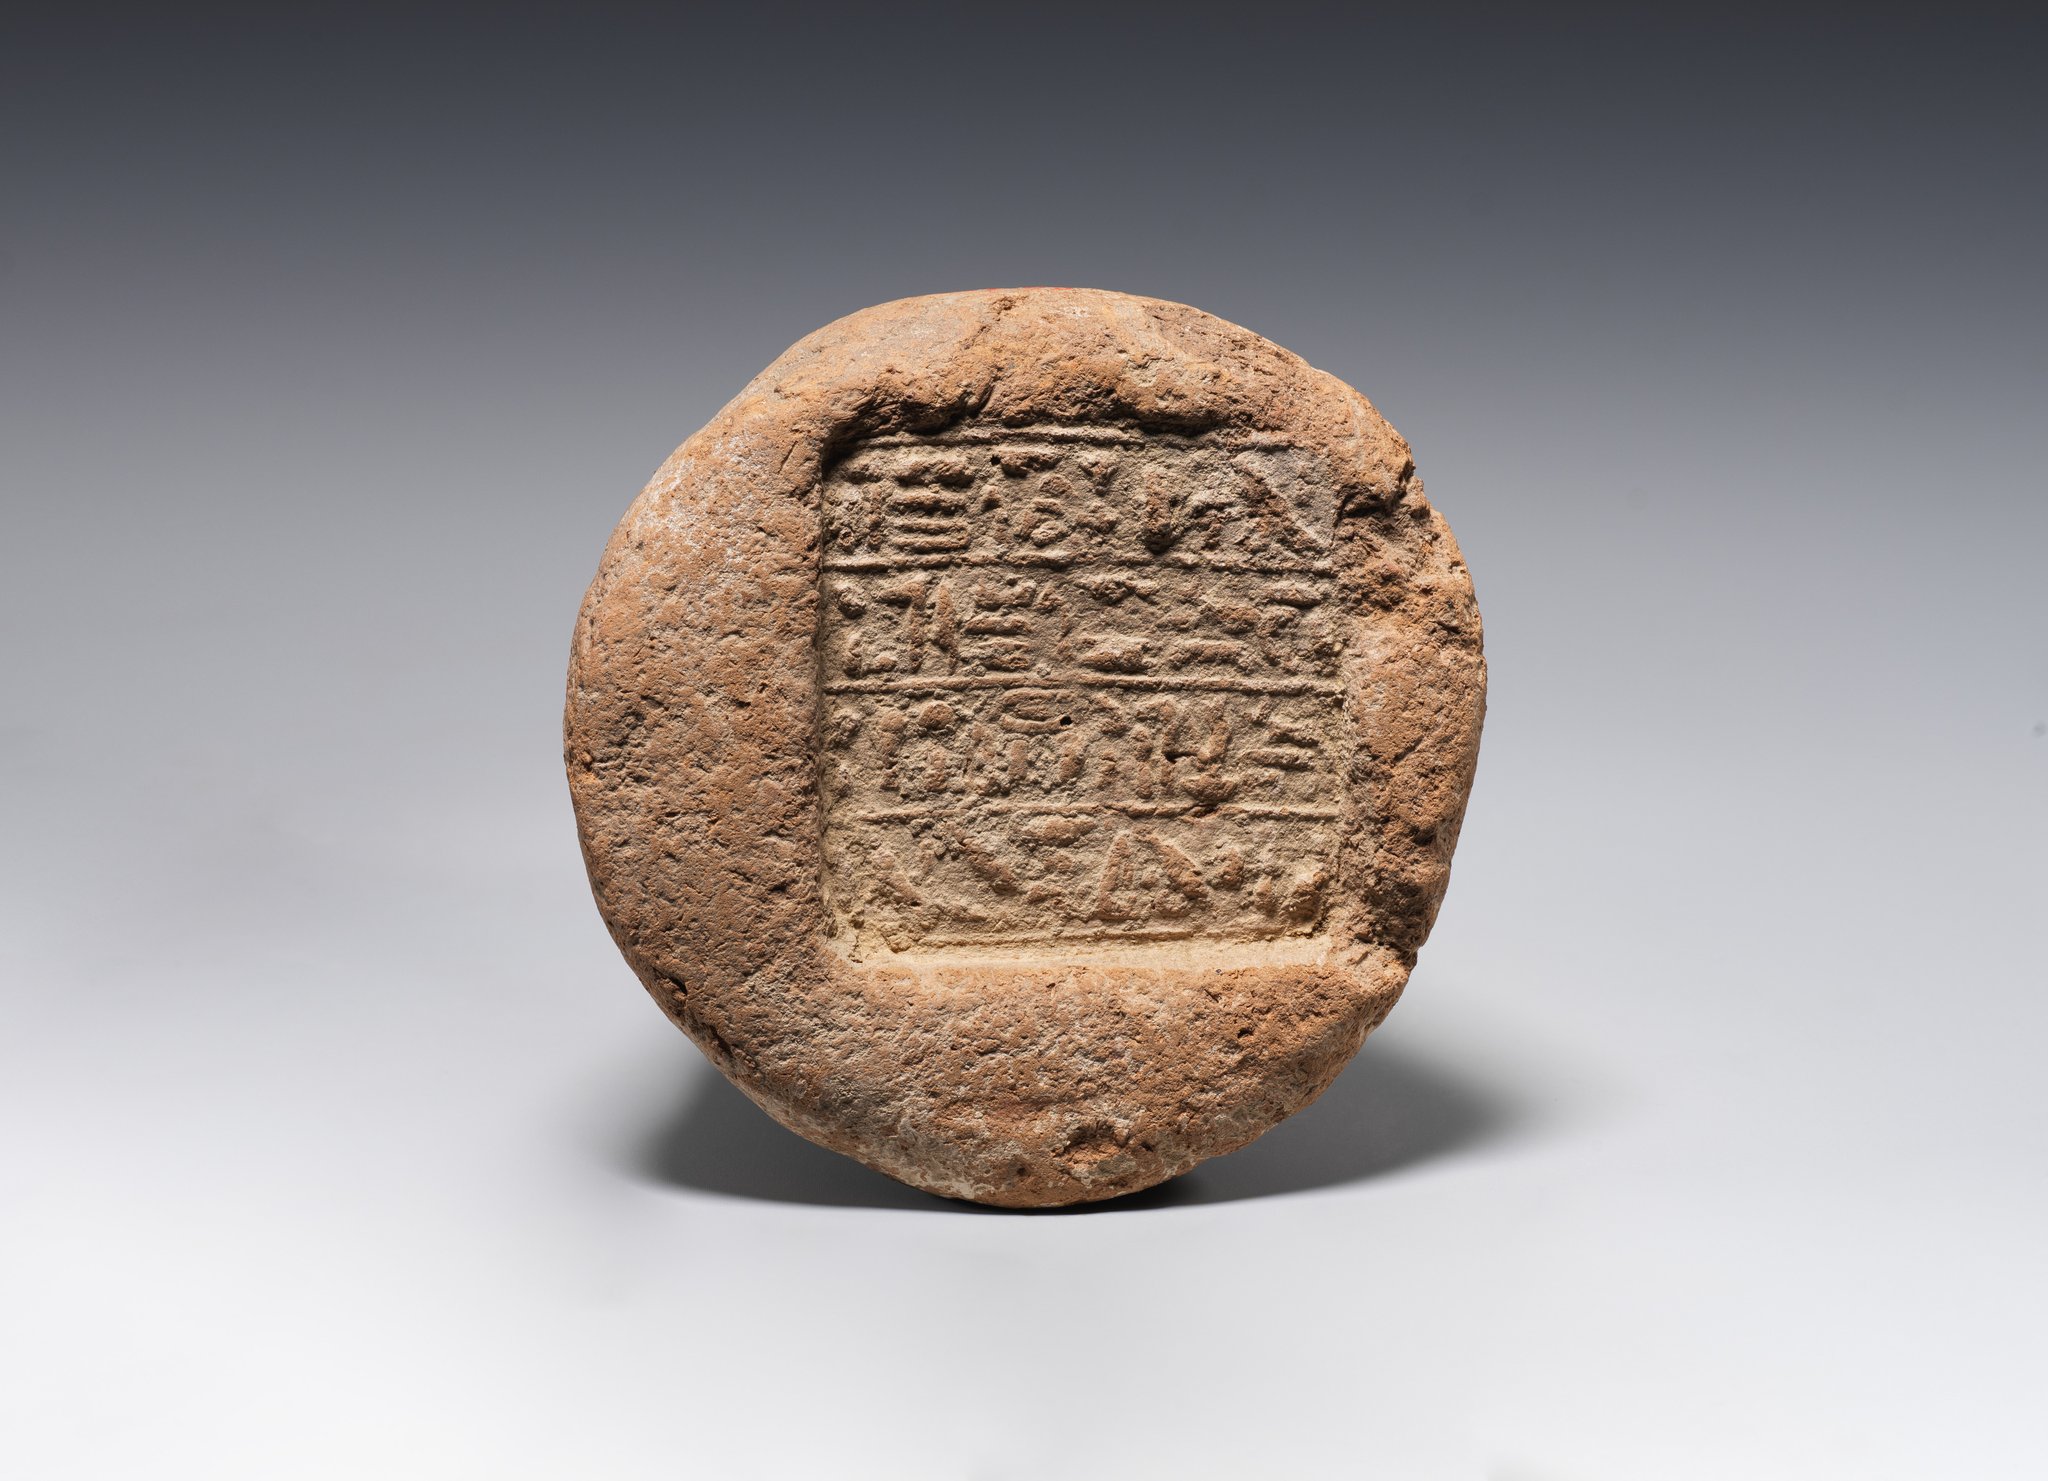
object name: funerary cone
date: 1550-1295 BCE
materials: pottery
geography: egypt